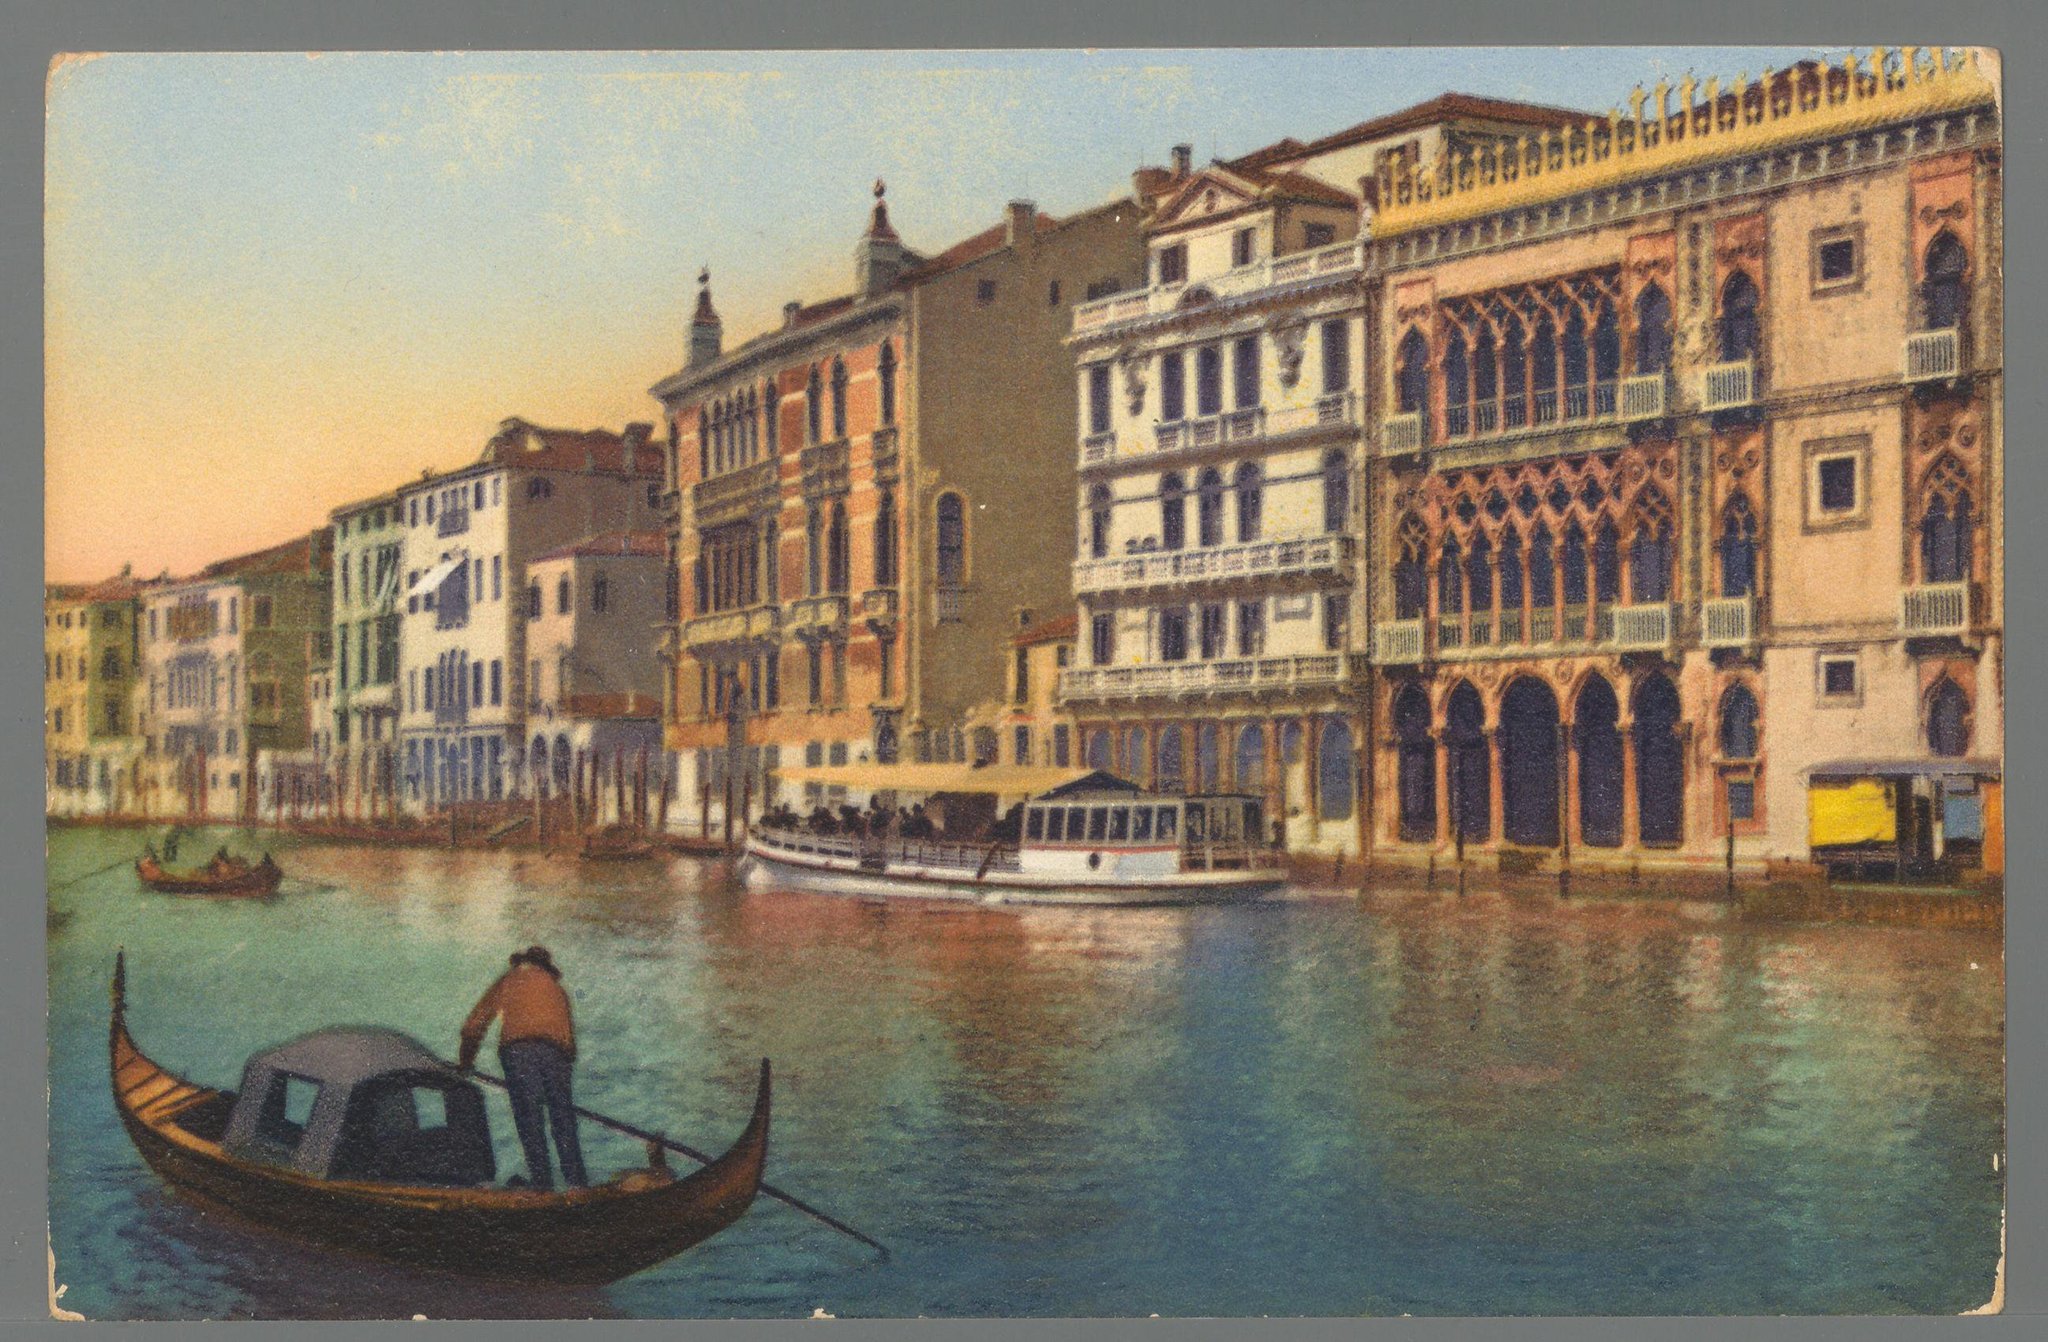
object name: ansichtkaart, prentbriefkaart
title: Venezia. Canal Grande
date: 1903-1925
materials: cardboard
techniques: lithograph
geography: zurich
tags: canal, gondola, city-view, and landscape with man-made constructions (+ city(-scape) with figures, staffage)